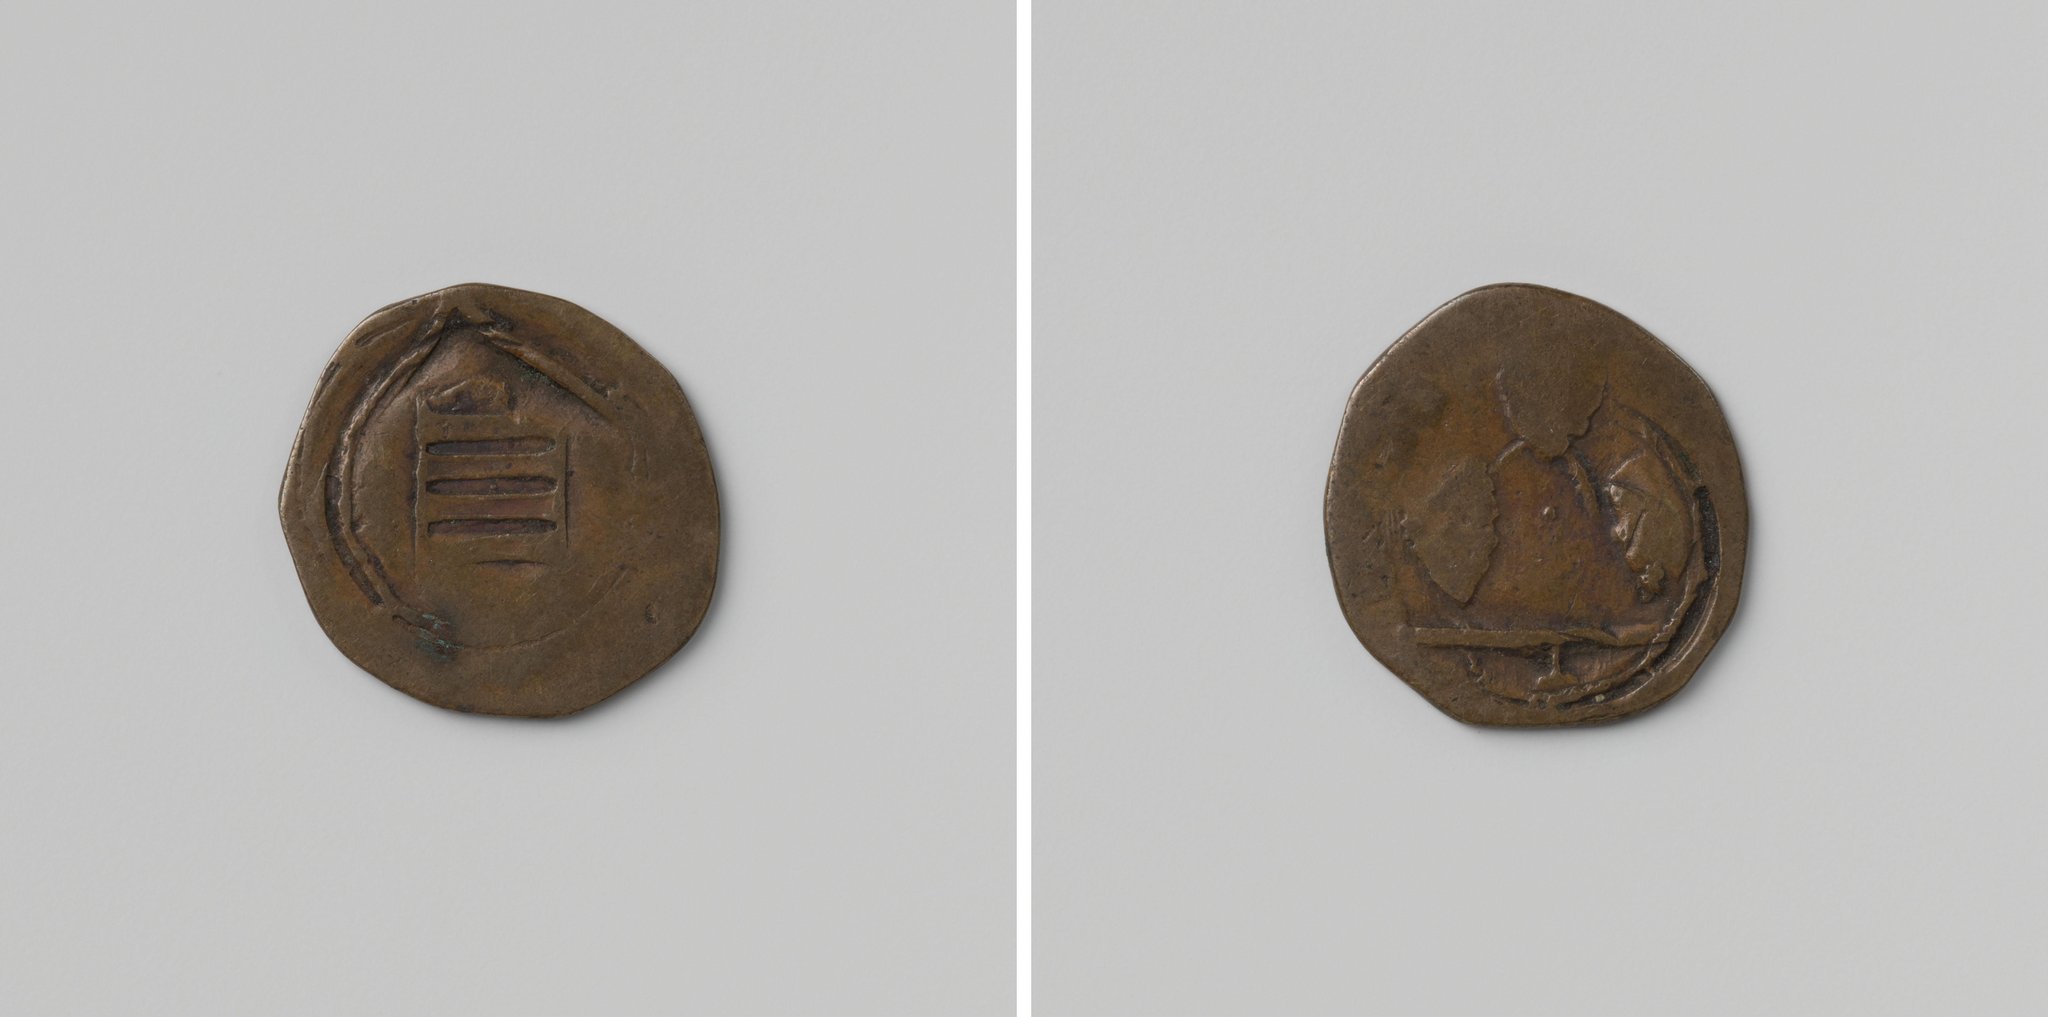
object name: avondmaalspenning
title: Kerk van St. Omer, avondmaalspenning met no. 4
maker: Anonymous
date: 1600-1800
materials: copper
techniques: striking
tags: saint-omer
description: Koperen penning. Voorzijde: wapenschild. Keerzijde: monogram.